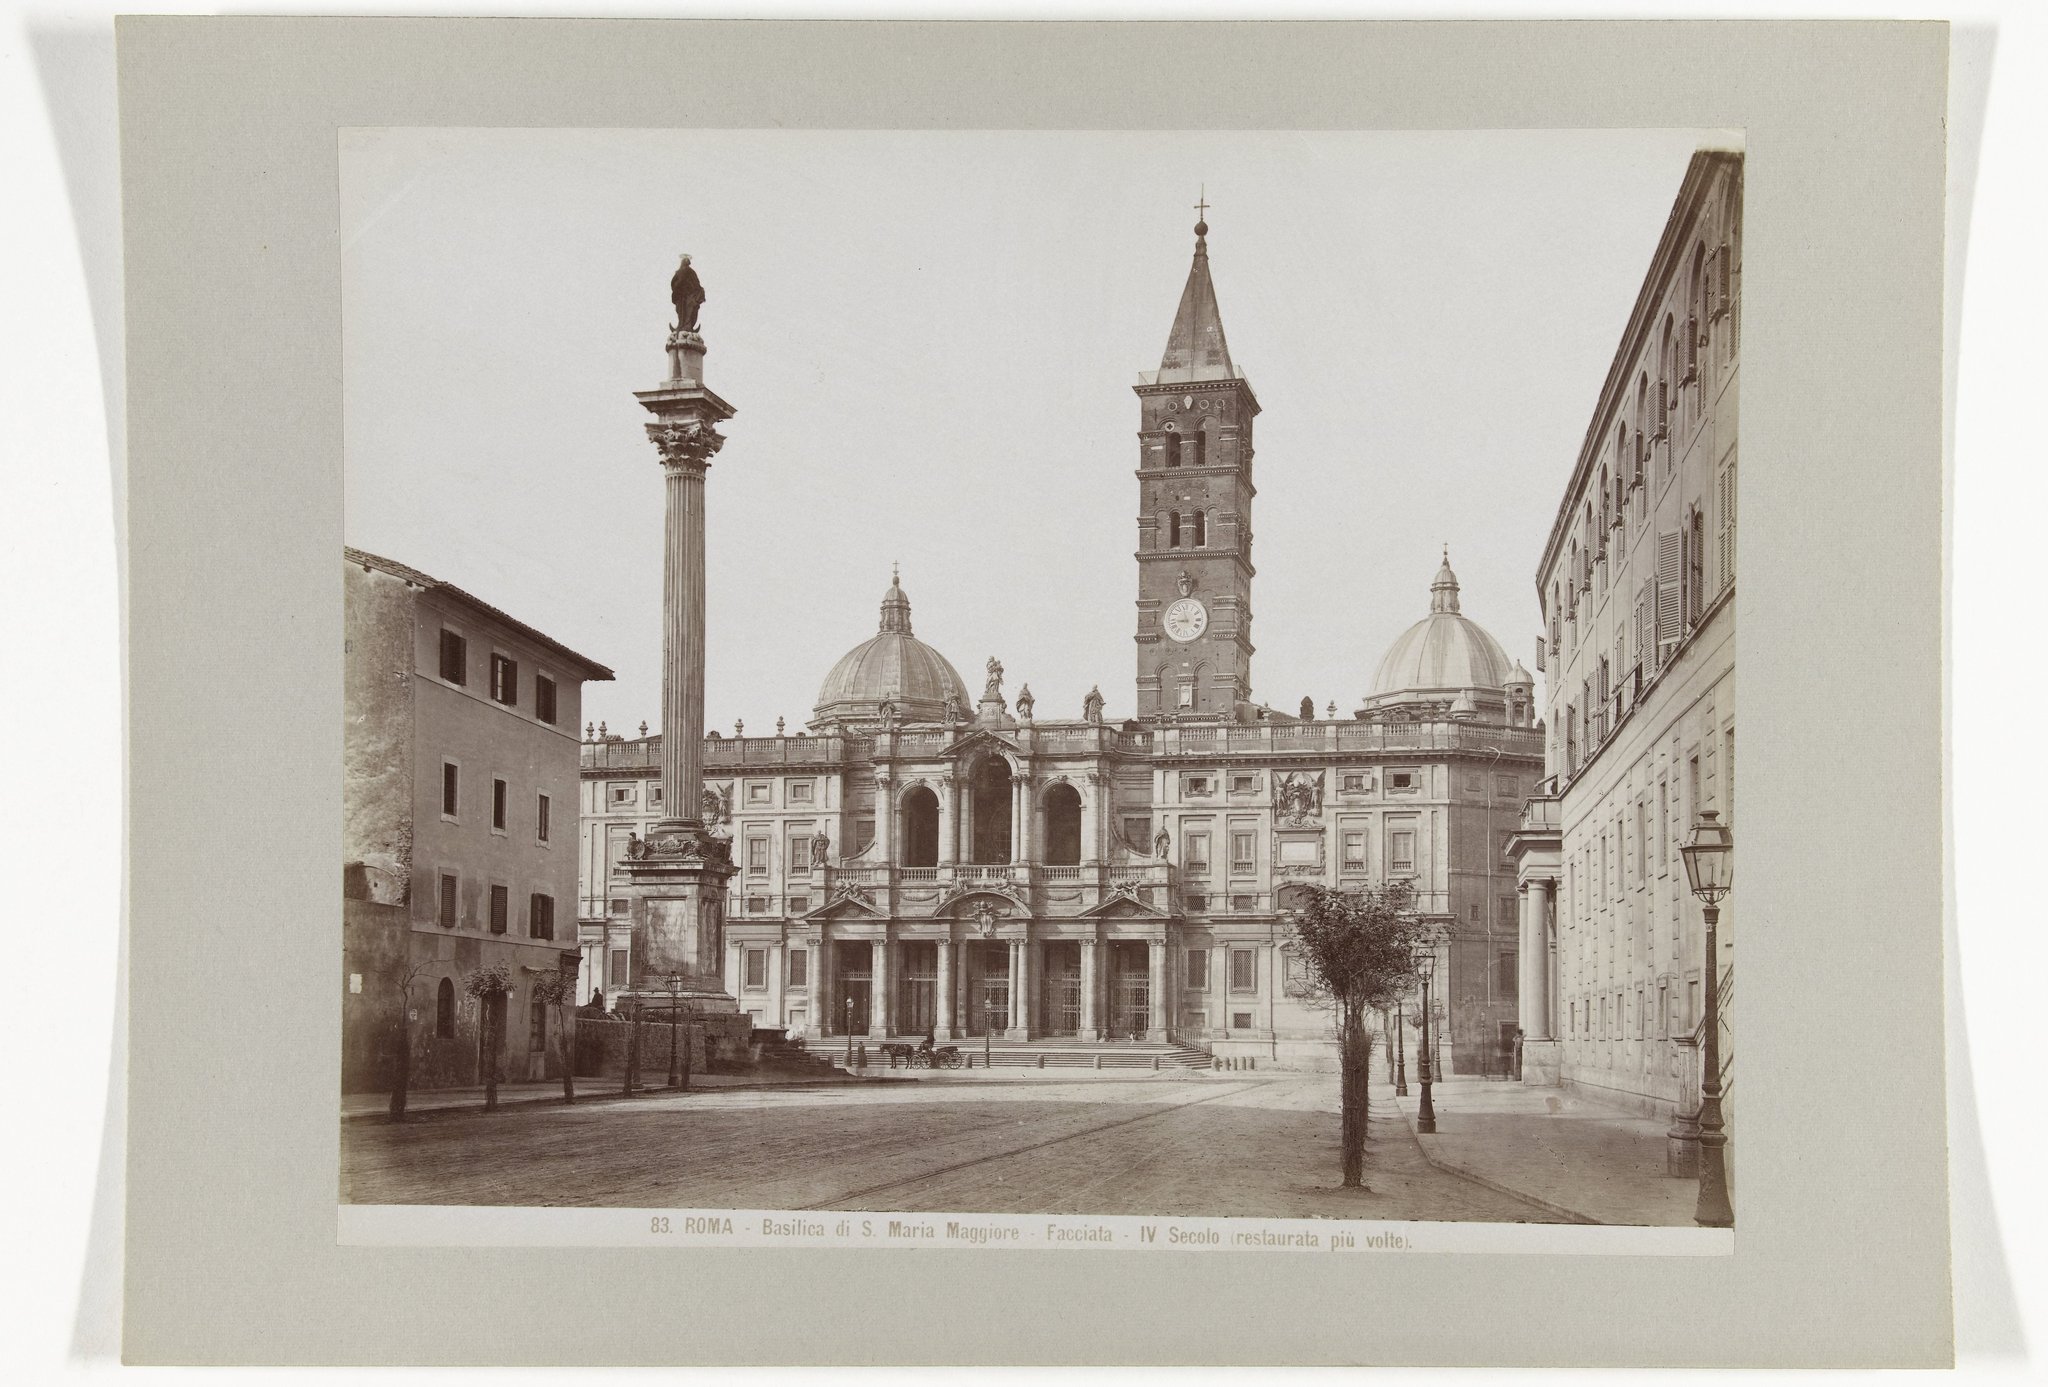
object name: photograph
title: 83. Roma - Basilica di S. Maria Maggiore - Facciata - IV Secolo (restaurata piú volte).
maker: Anonymous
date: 1880-1904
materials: cardboard, paper, photographic support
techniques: albumen print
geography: rome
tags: santa maria maggiore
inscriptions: number: ‘8.’